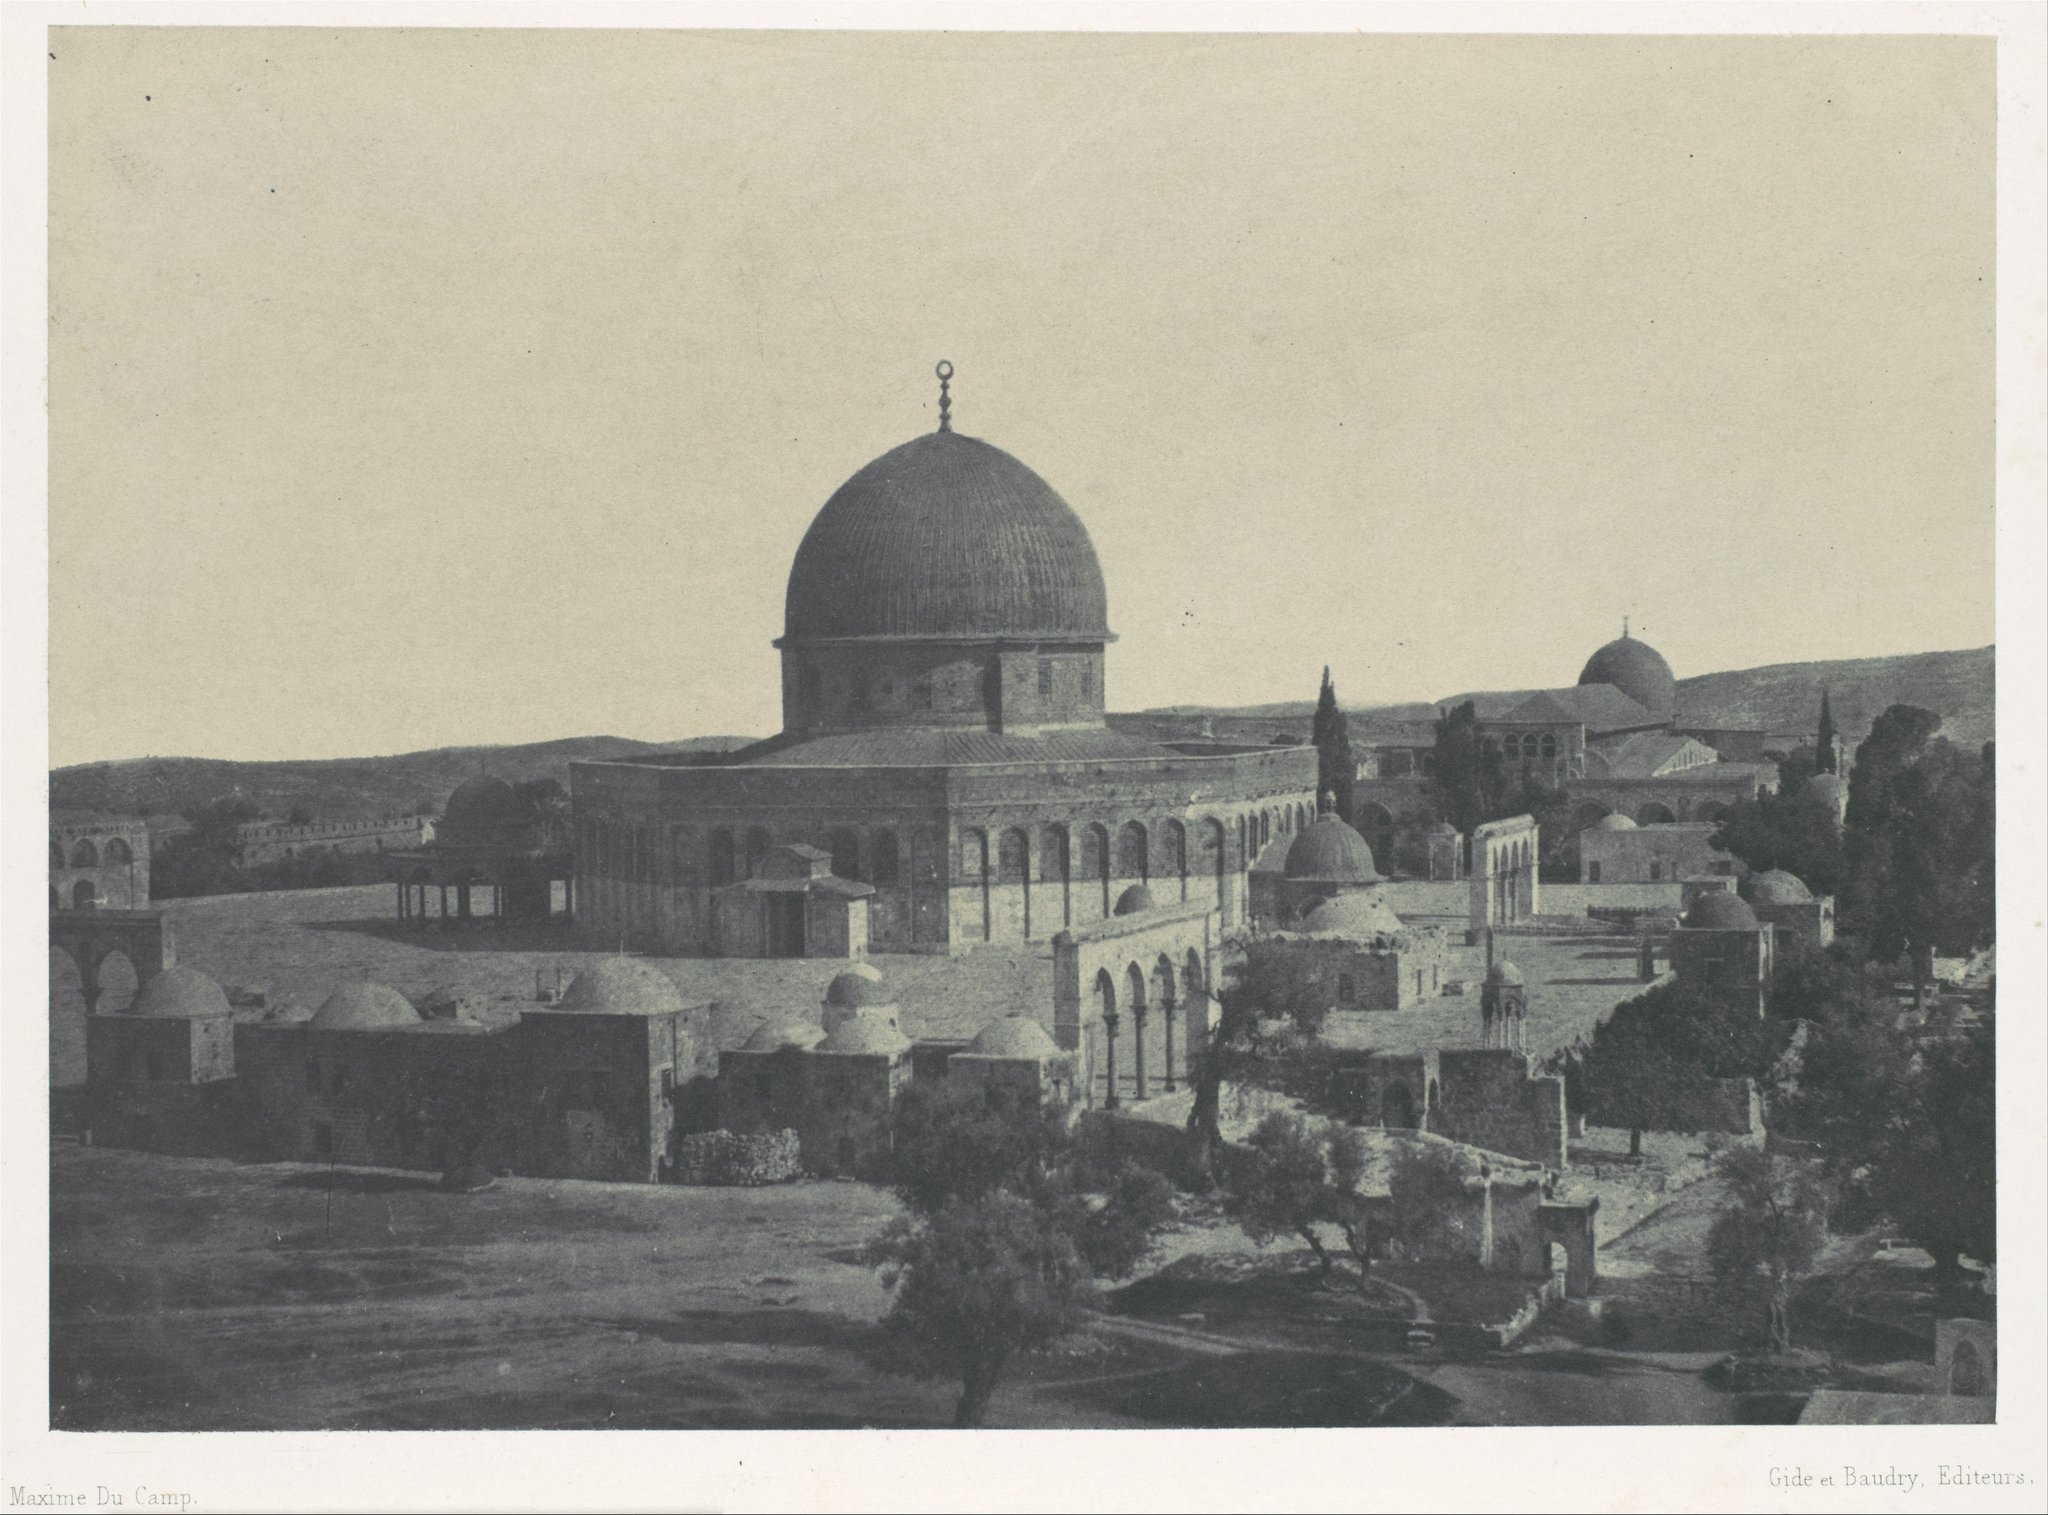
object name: photograph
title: Palestine. Jérusalem. Mosquée d'Omar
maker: maxime du camp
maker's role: artist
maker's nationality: french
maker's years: 1822-1894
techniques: paper negative, salted paper print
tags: architecture,mosques